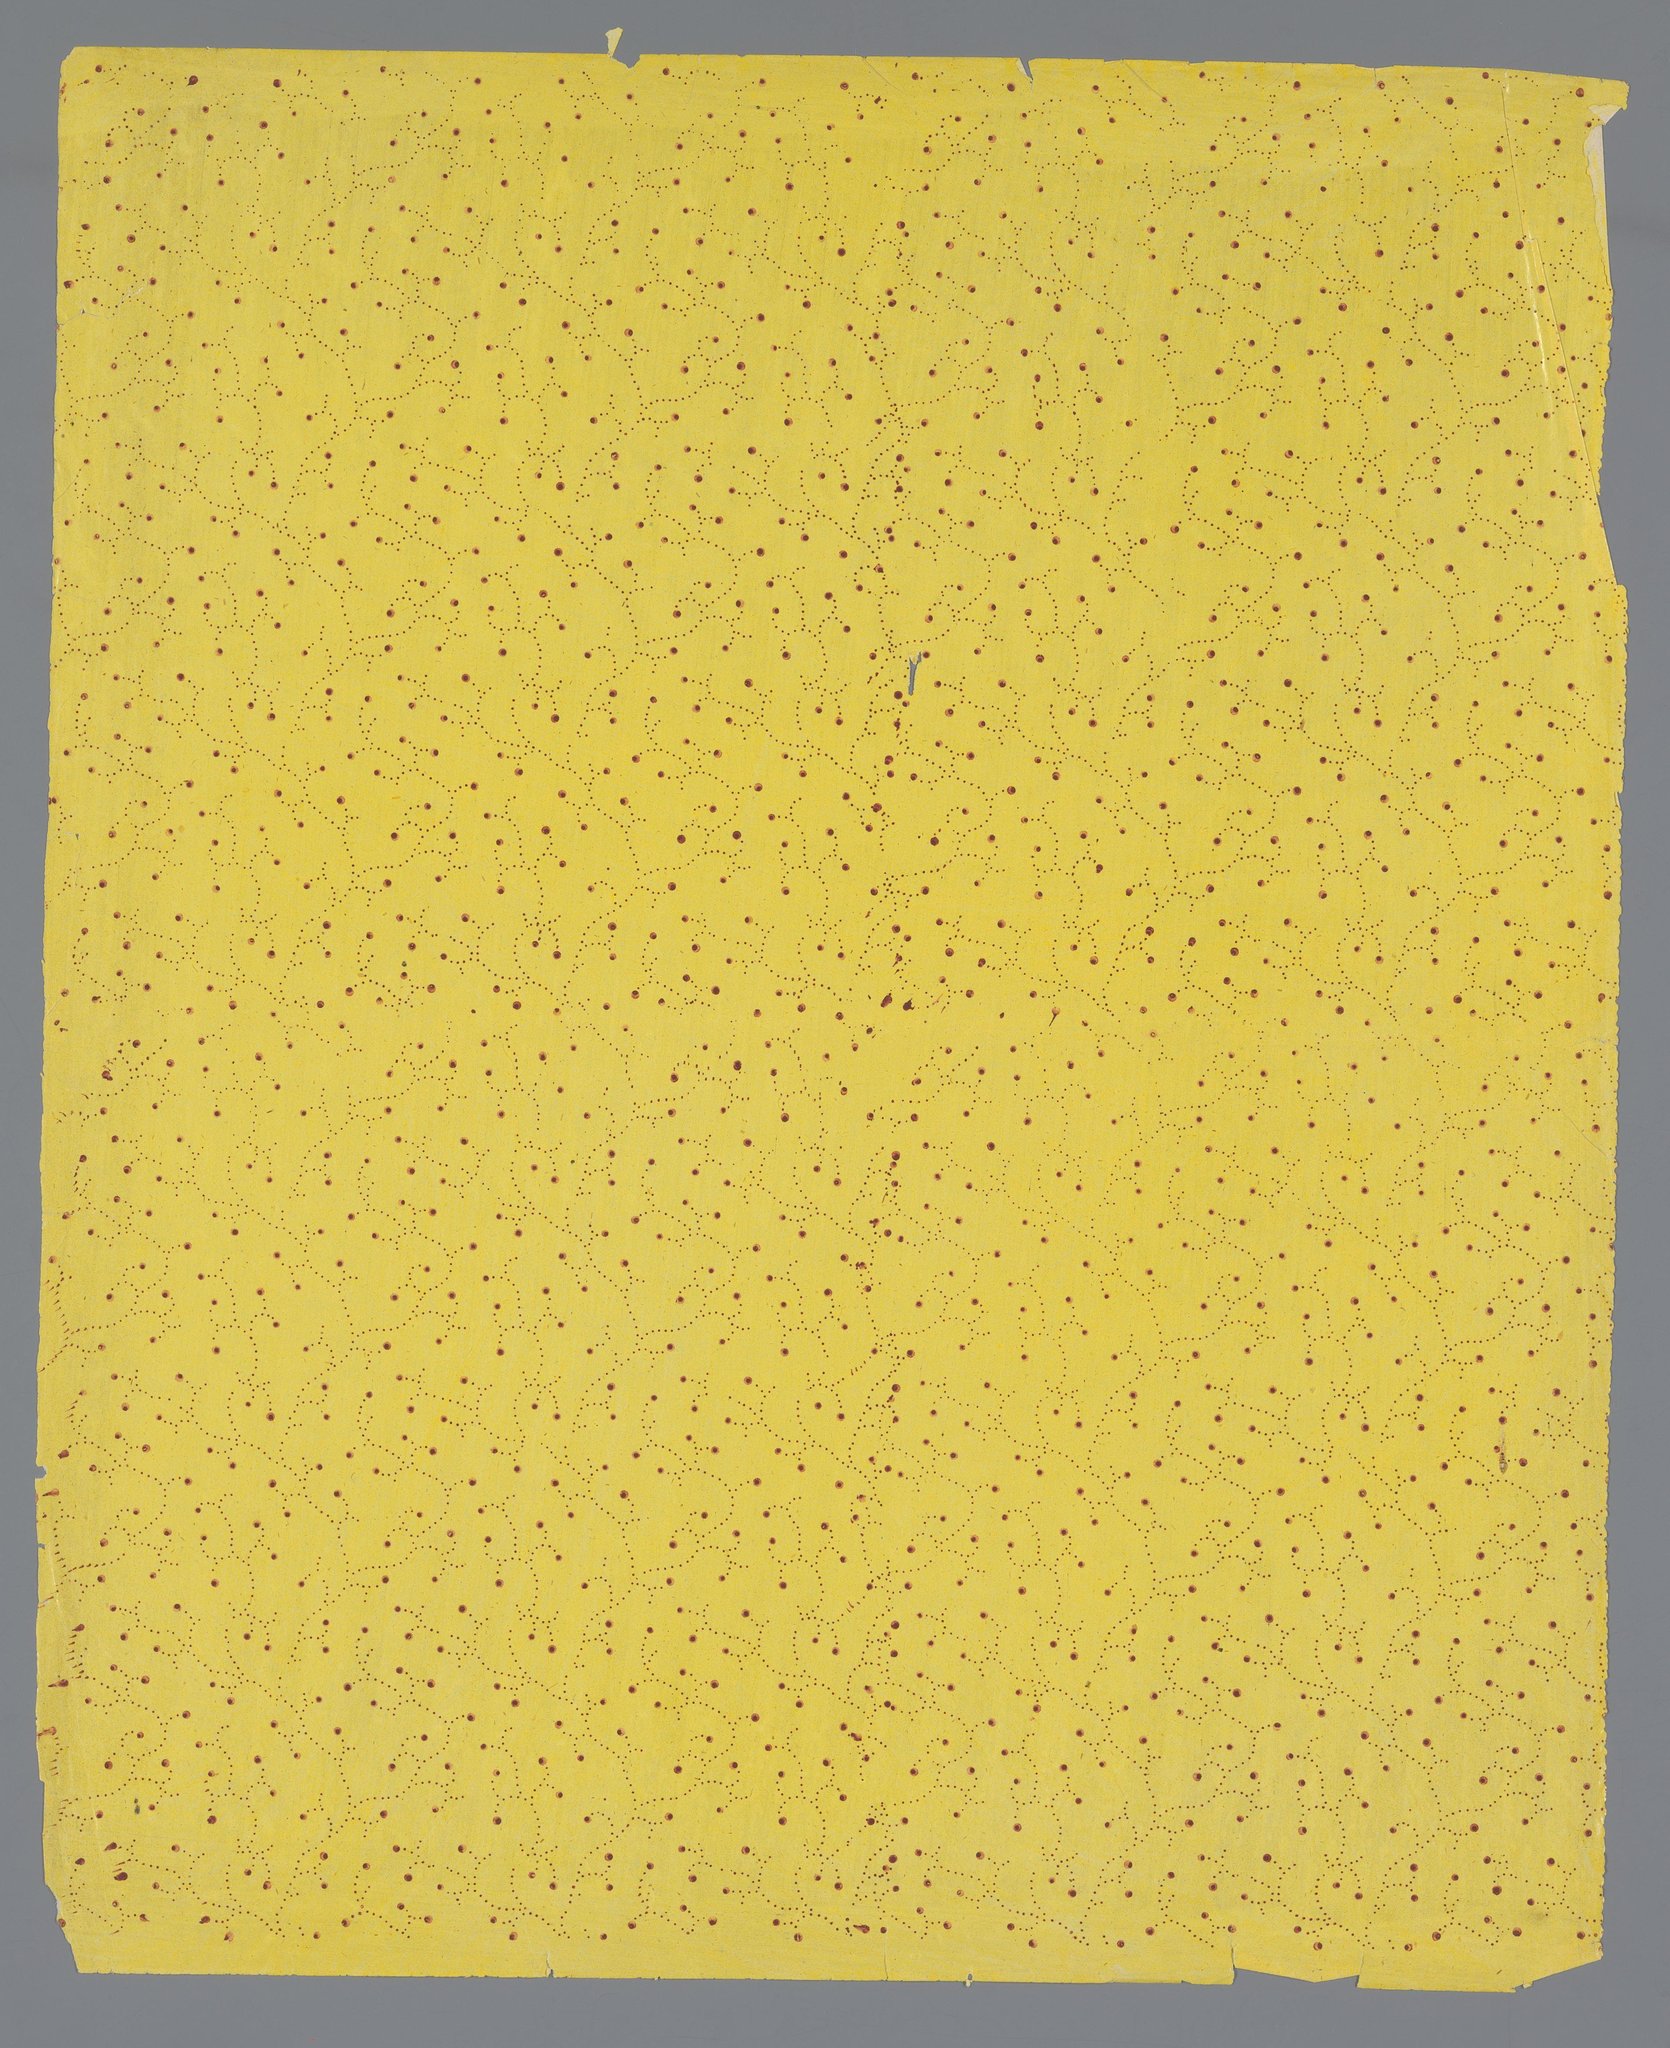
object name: printed paper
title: Blad met patroon van stippellijnen en punten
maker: Anonymous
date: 1850-1950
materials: lacquer, paint, paper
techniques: printing block, lacquer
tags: ornament derived from plant forms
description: Blad met een rankenpatroon van stippellijnen en punten.